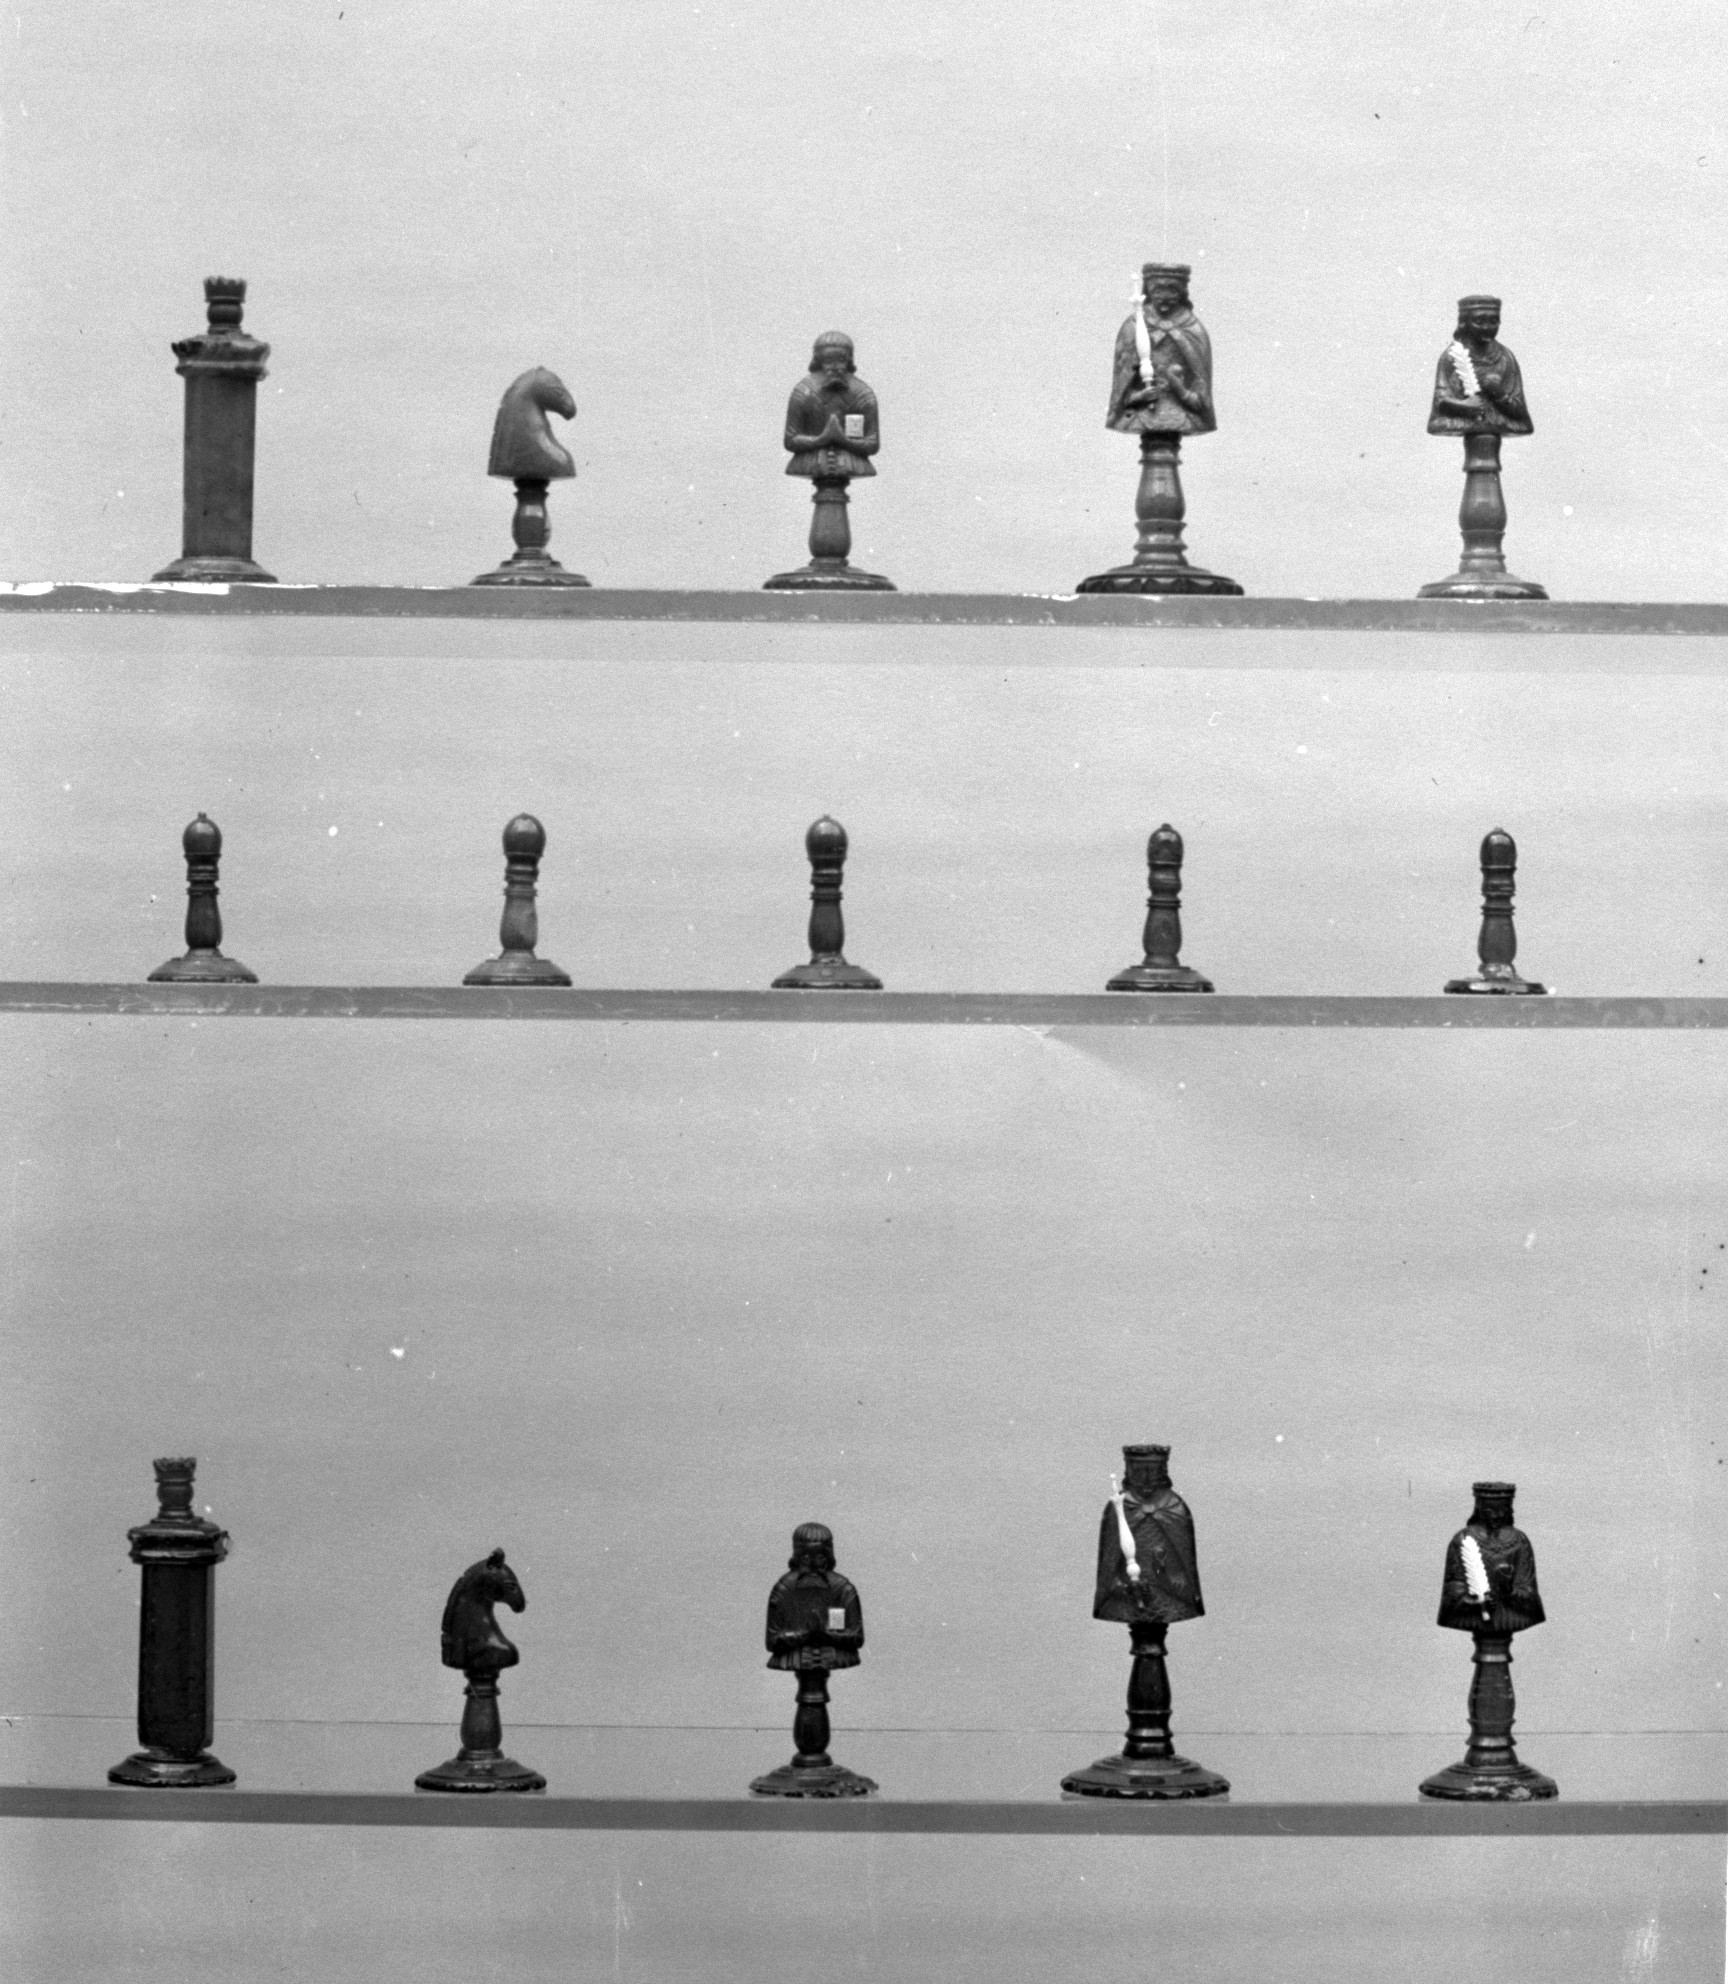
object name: chessman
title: Chessmen (32)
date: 1701-1900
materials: amber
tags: chess,games